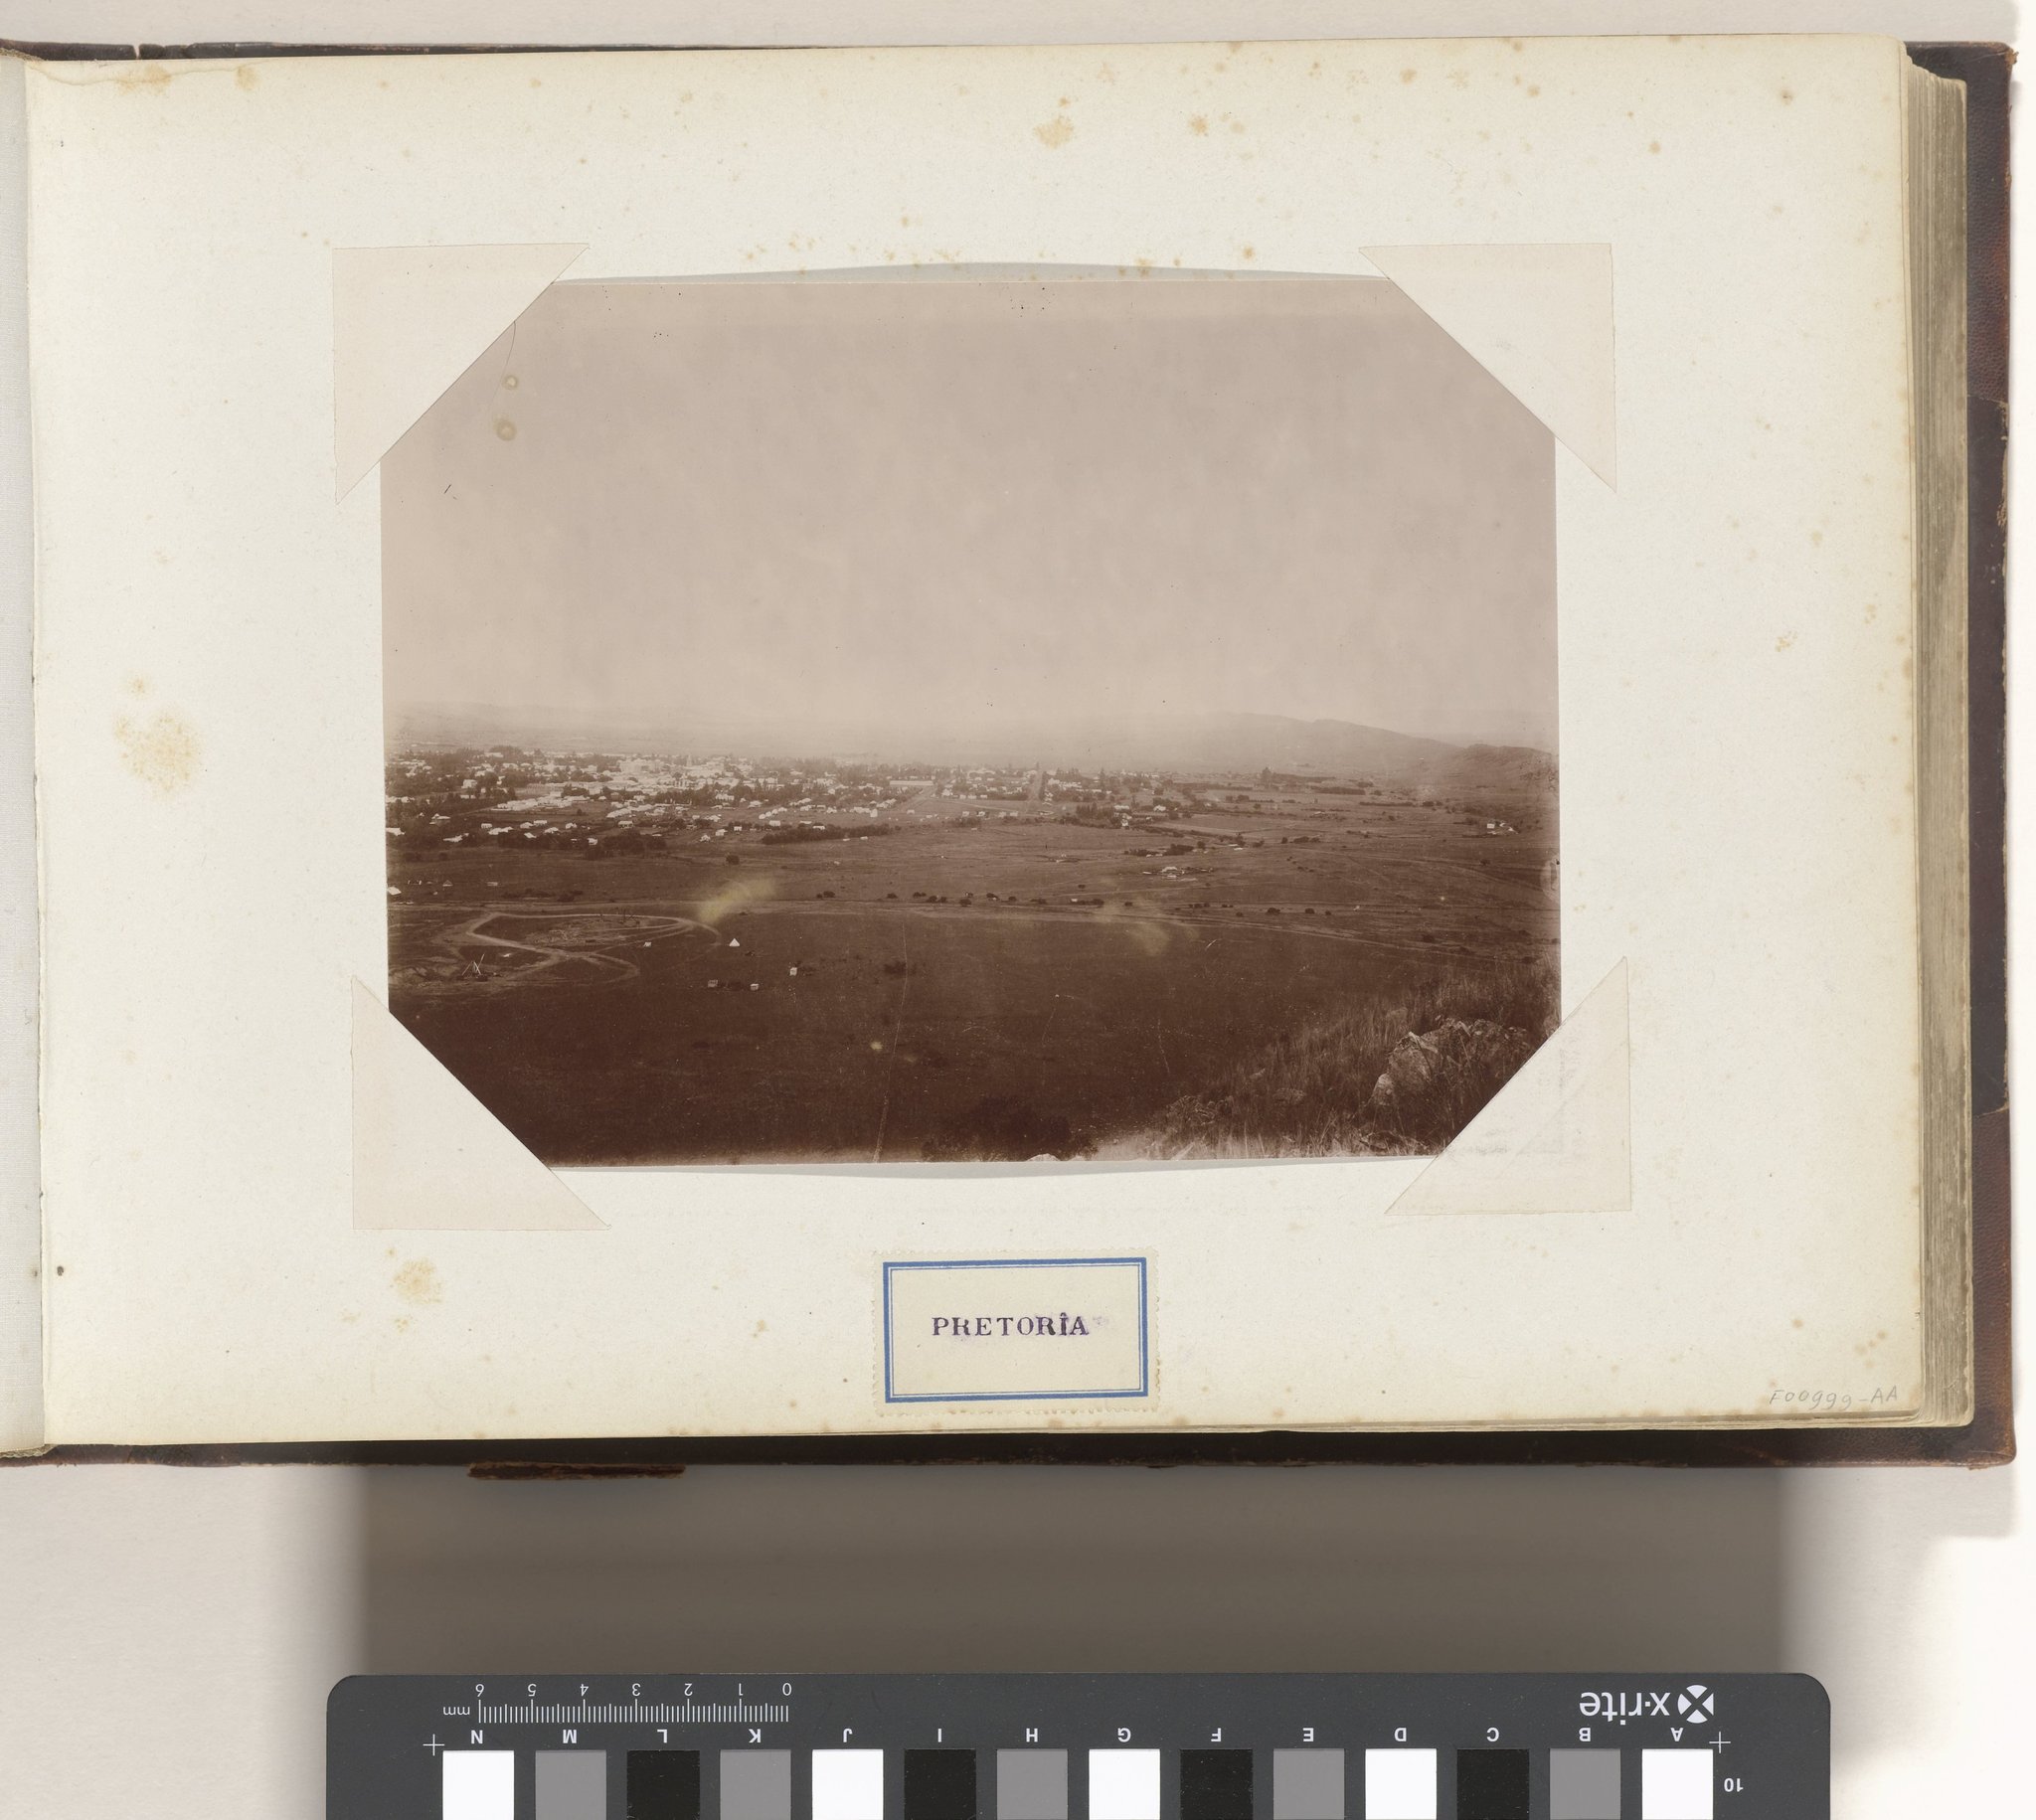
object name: photograph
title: Gezicht op Pretoria en het landschap eromheen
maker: Anonymous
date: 1885-1910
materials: paper, photographic support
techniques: collodion silver print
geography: pretoria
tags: prospect of city, town panorama, silhouette of city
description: Onderdeel van Album met 191 foto's van een reis naar en door Zuid-Afrika.